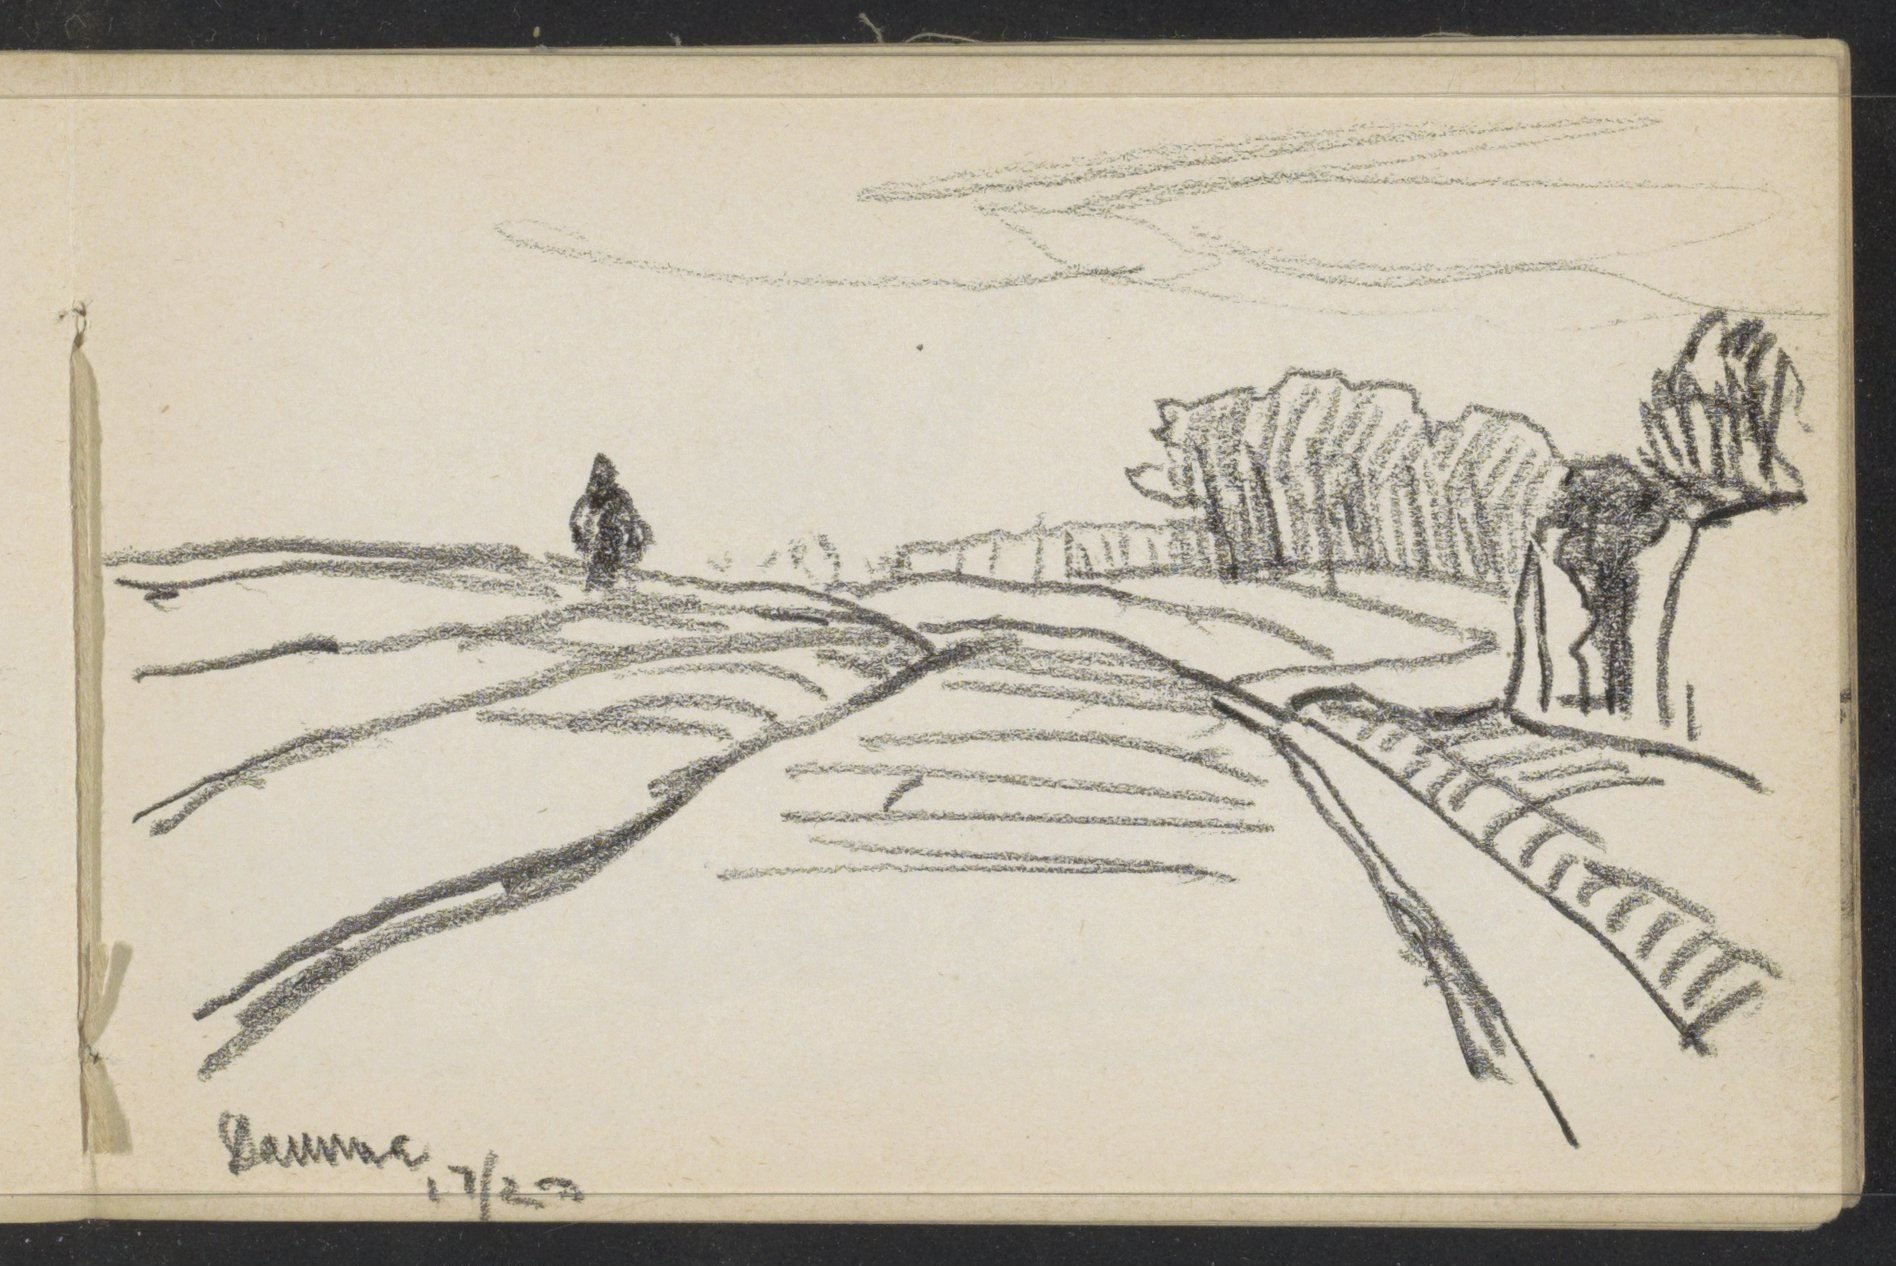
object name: sketchbook leaf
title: Akkerland te Damme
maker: alexander shilling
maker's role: draughtsman, print maker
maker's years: 1859-1937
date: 1910-1923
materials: chalk, paper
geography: damme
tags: landscapes (+ landscape with figures, staffage)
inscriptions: date and inscription: ‘Damme 17/ 23’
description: Blad 8 recto uit een schetsboek met 26 bladen.